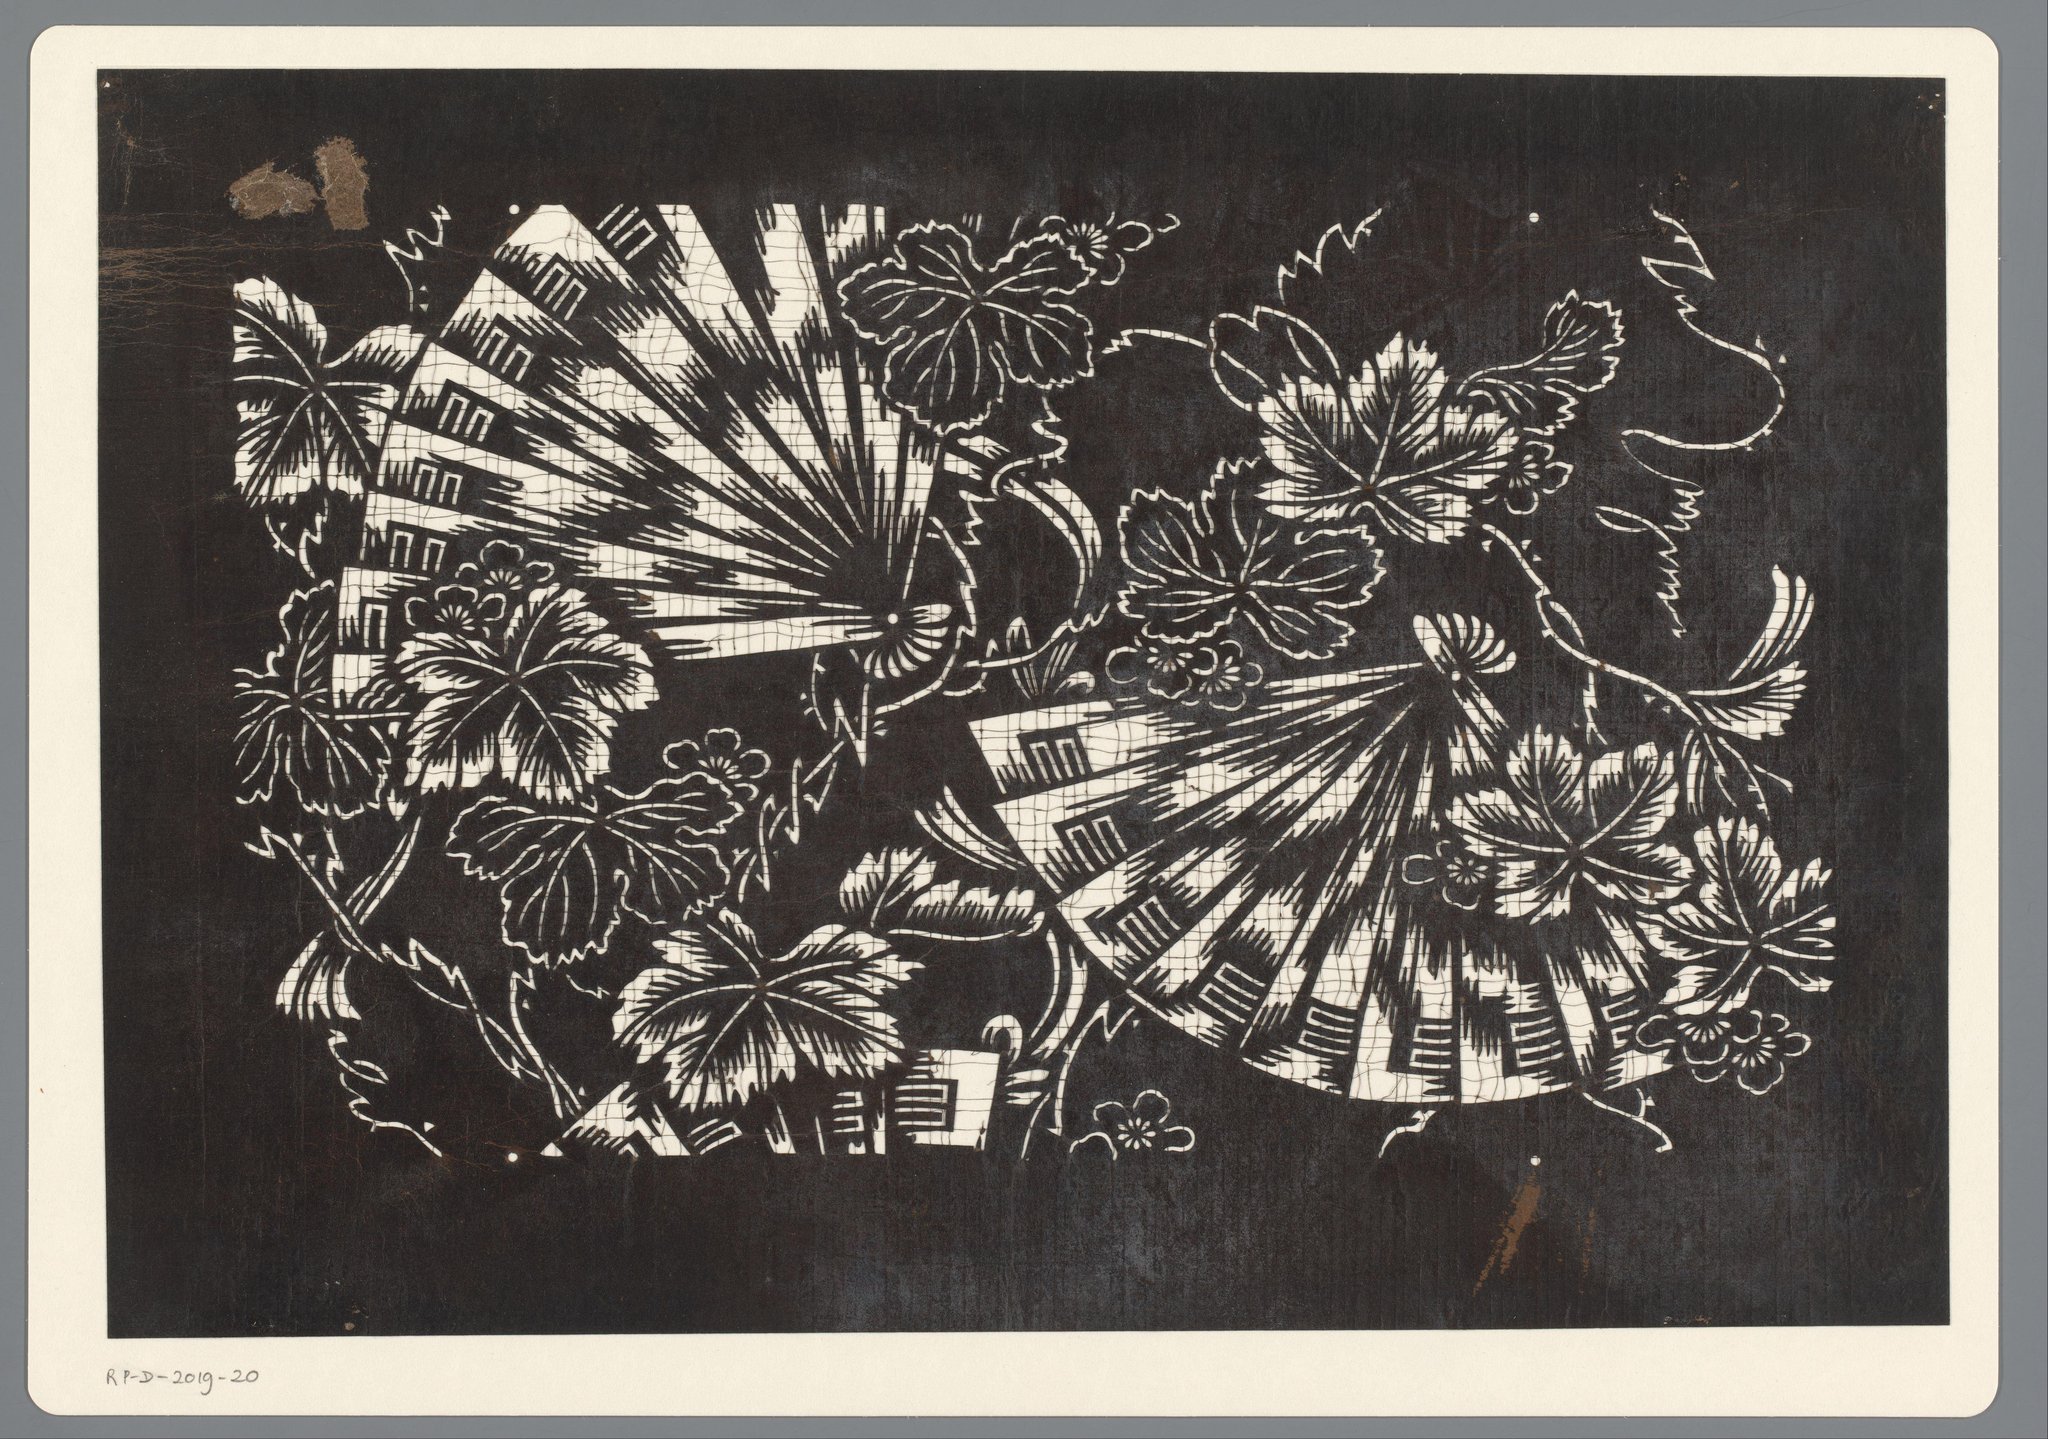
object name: katagami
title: Sjabloon met waaiers en bladeren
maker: Anonymous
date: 1800-1909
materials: paper, silk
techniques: cutting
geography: japan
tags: fan, ornament derived from plant forms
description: Japanse sjabloon (katagami) met een patroon van waaiers en bladeren.